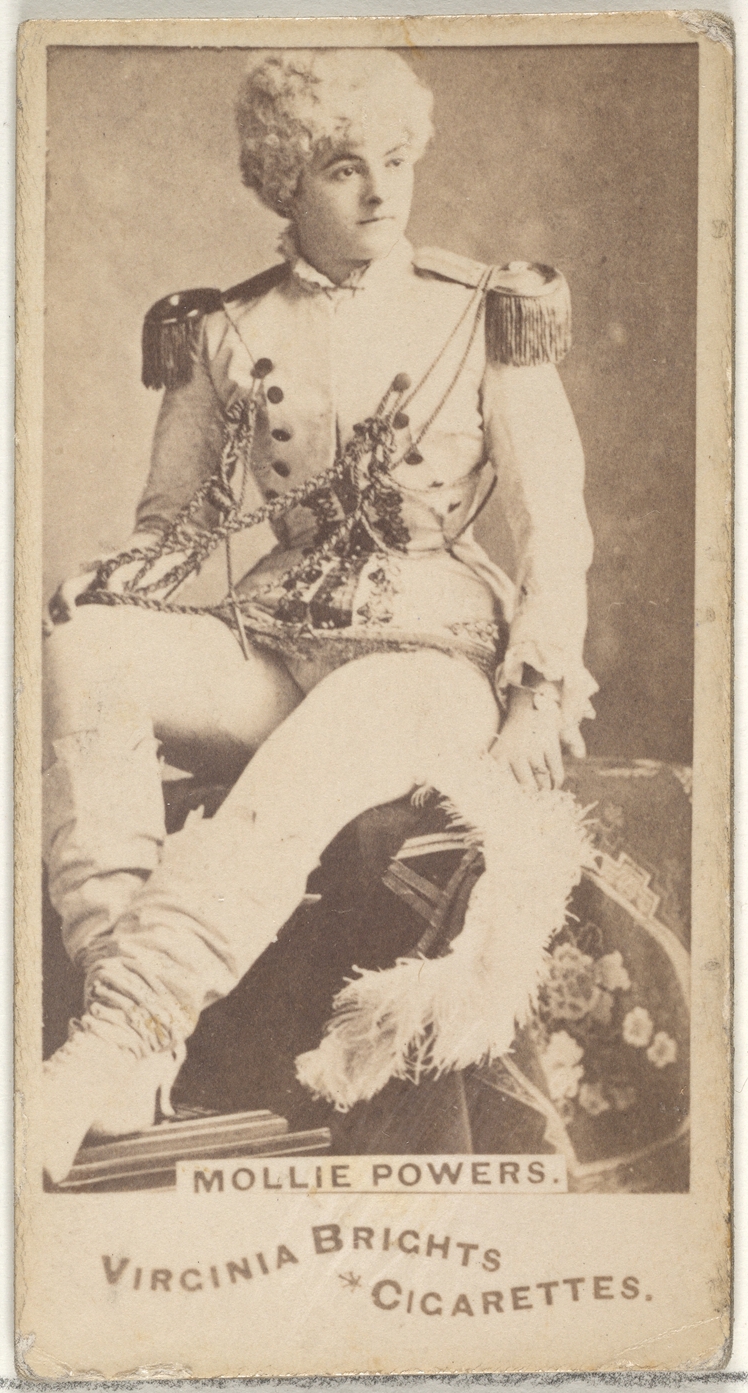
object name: photograph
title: Mollie Powers, from the Actors and Actresses series (N45, Type 1) for Virginia Brights Cigarettes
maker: allen & ginter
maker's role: publisher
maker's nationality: american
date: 1888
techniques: albumen silver print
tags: portraits,women,actresses